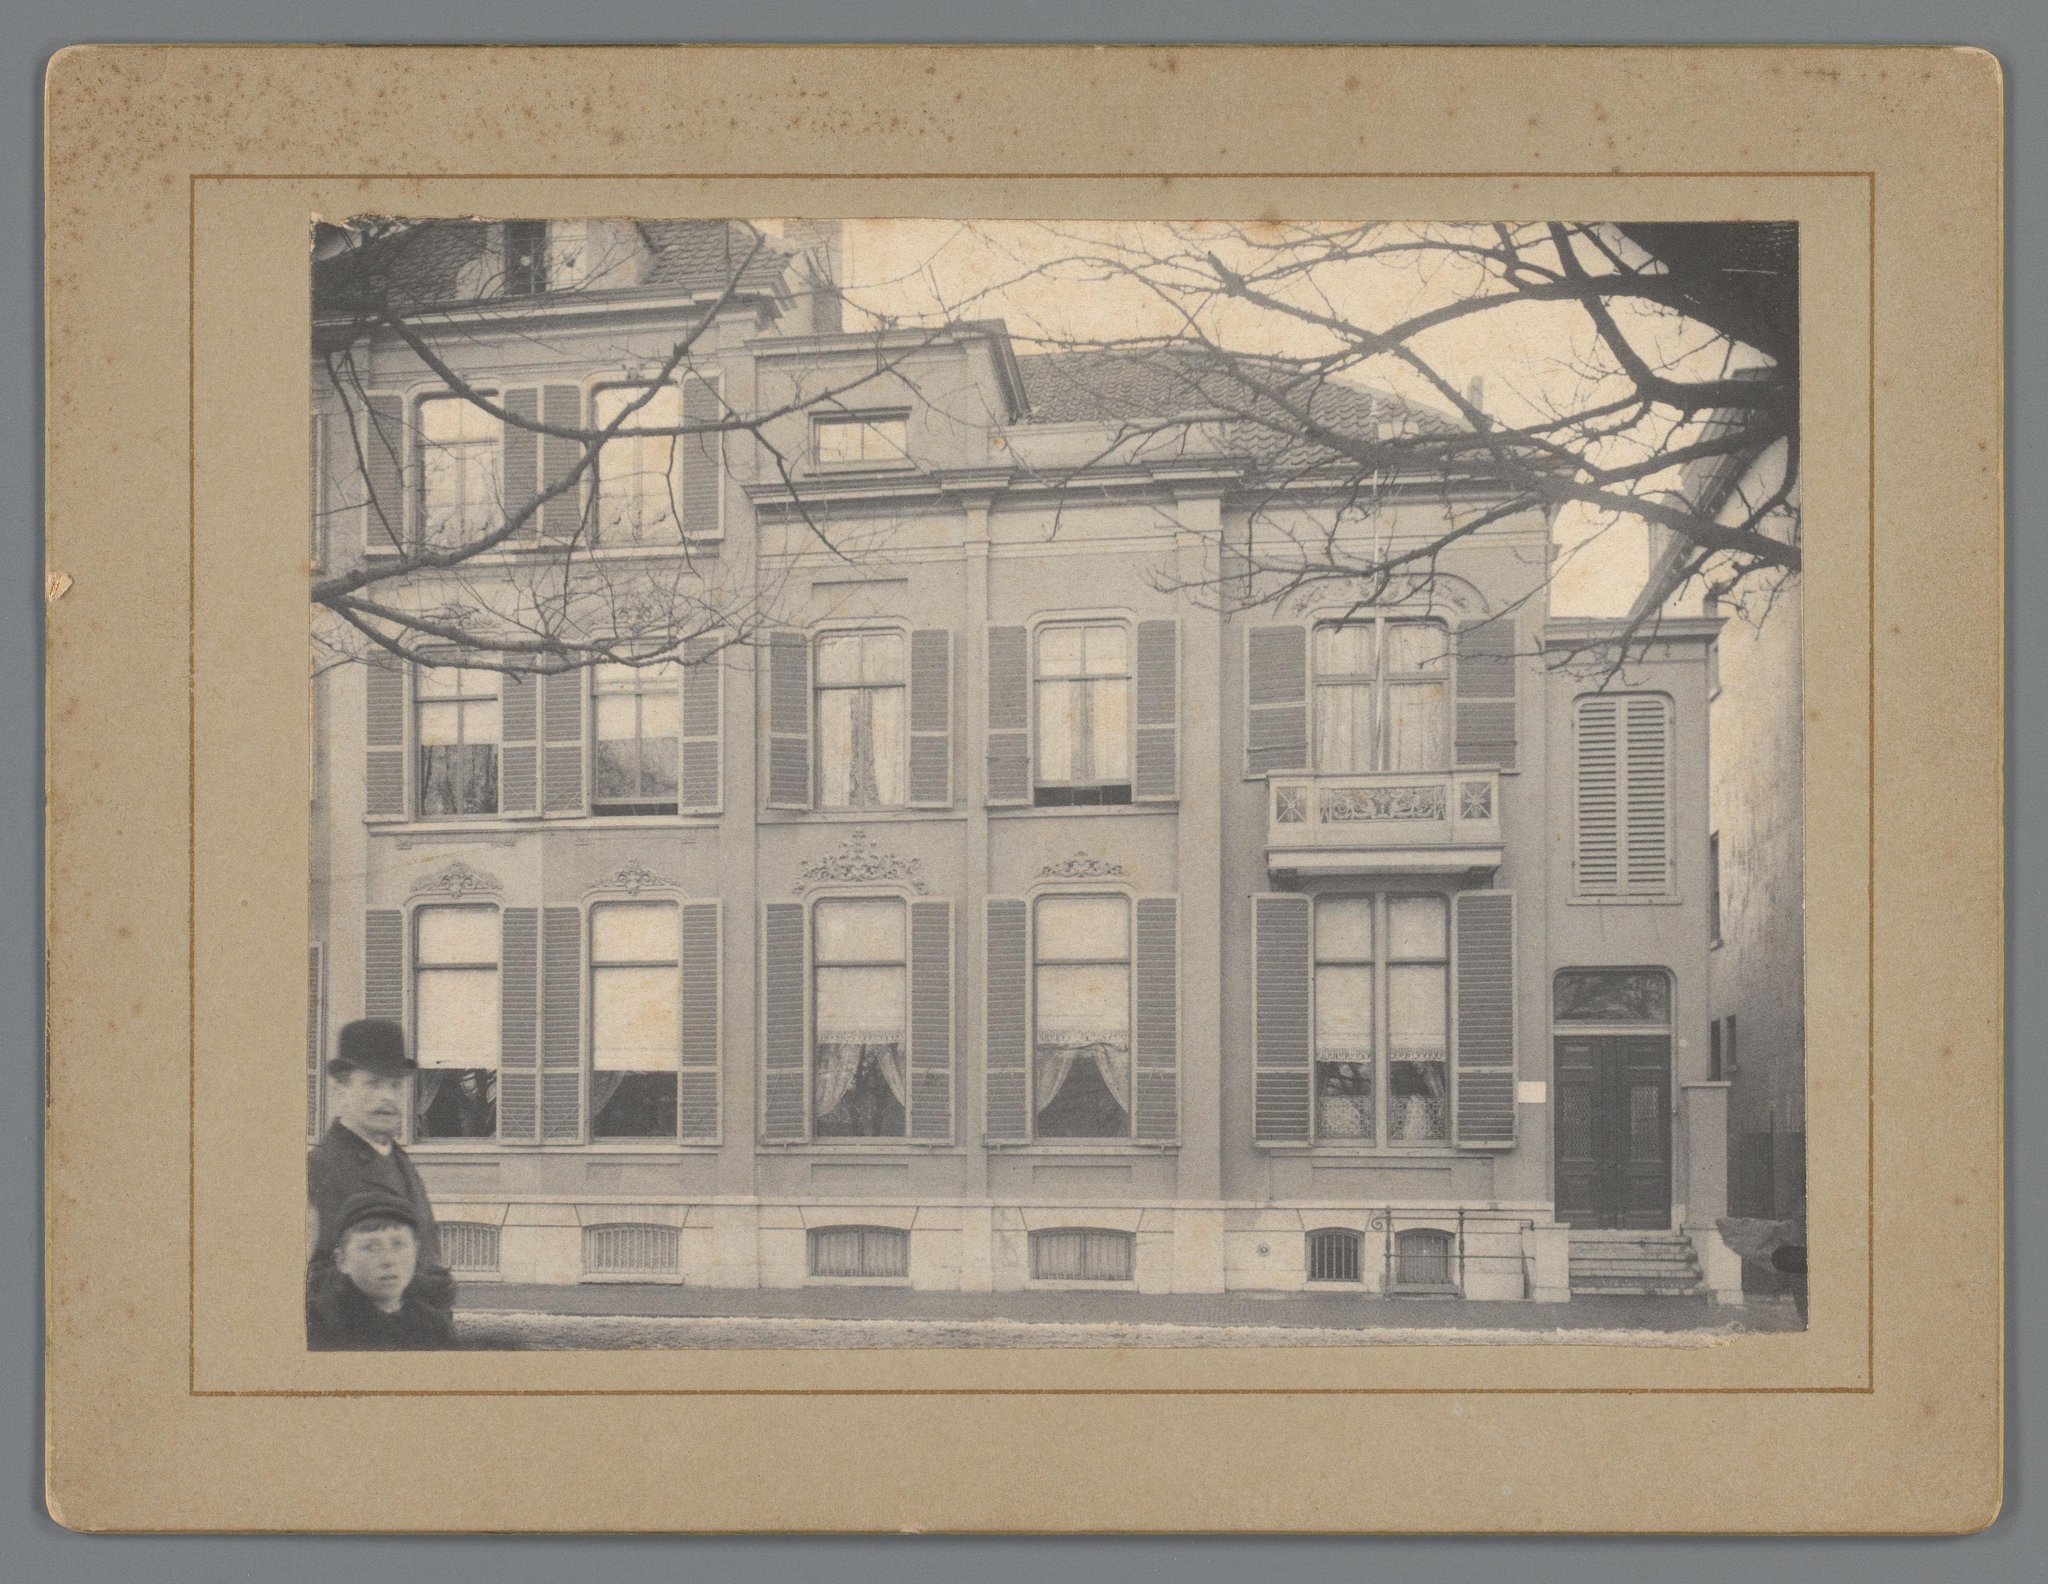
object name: photograph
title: Exterieur van het huis van Piet de Jong in Arnhem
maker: piet de jong (fotograaf)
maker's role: arts, fotograaf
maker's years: 1862-1934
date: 1900-1917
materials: cardboard, paper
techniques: gelatin silver print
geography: arnhem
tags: façade (of house or building)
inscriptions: inscription: ‘Velderplein 14/ Arnhem’